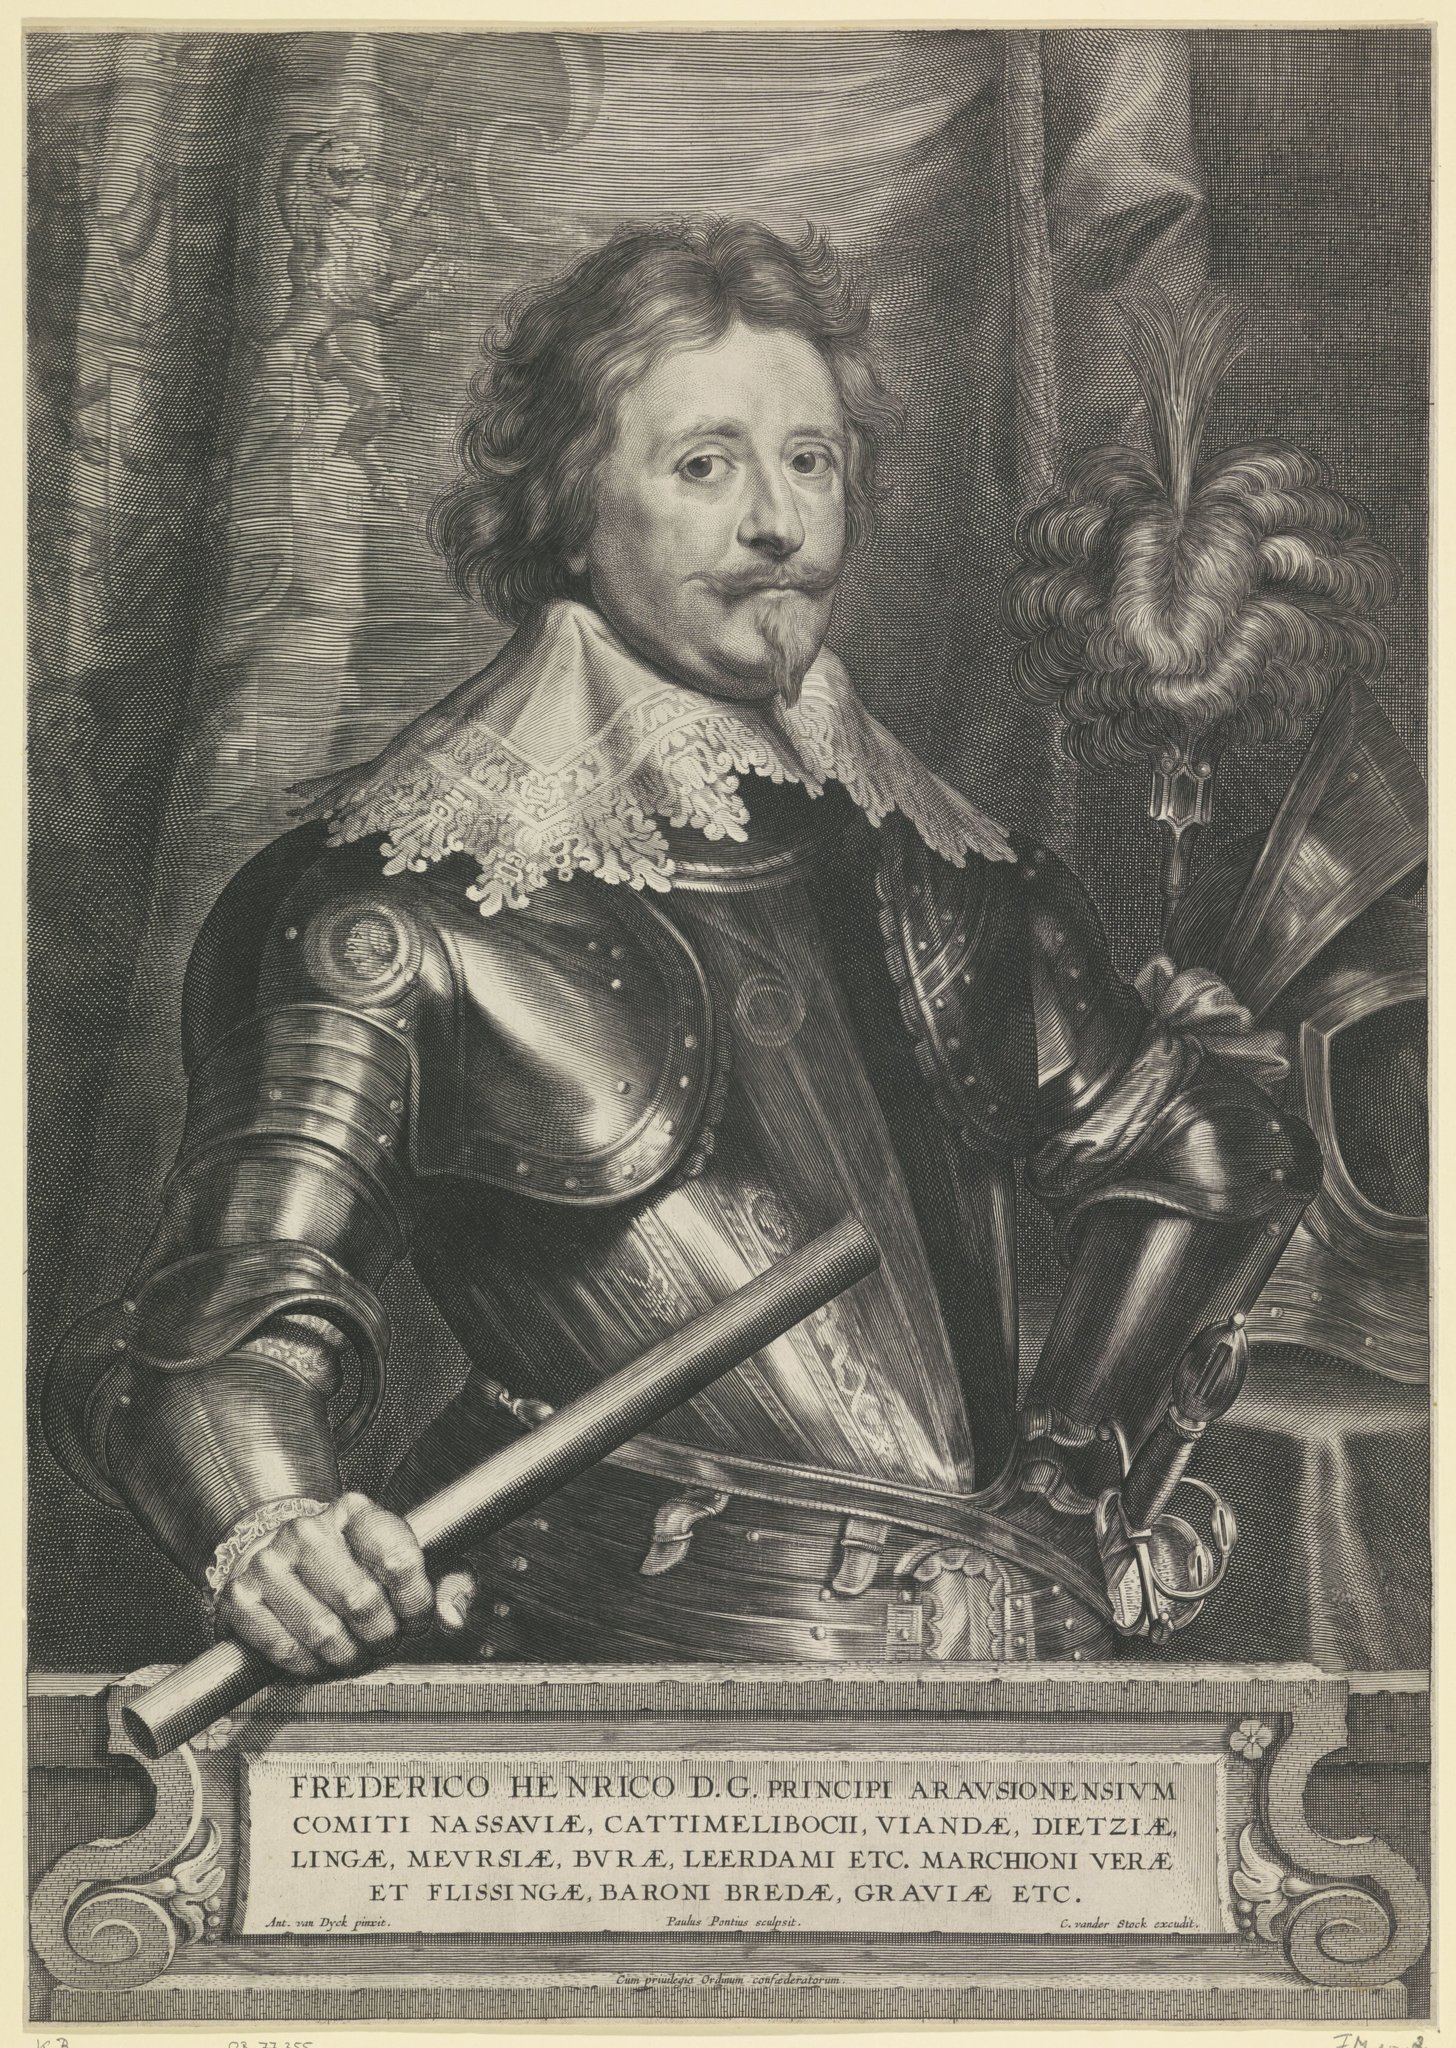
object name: print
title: Portret van Frederik Hendrik, prins van Oranje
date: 1650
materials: paper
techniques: engraving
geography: antwerp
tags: delft, the hague, frederick henry (prince of orange)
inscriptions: collector's mark: Lugt 240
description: Portret van Frederik Hendrik in wapenrusting staande voor een balustrade naar het schilderij van Anthonie van Dyck. Onderaan een cartouche met naam en titels van de geportretteerde in het Latijn.